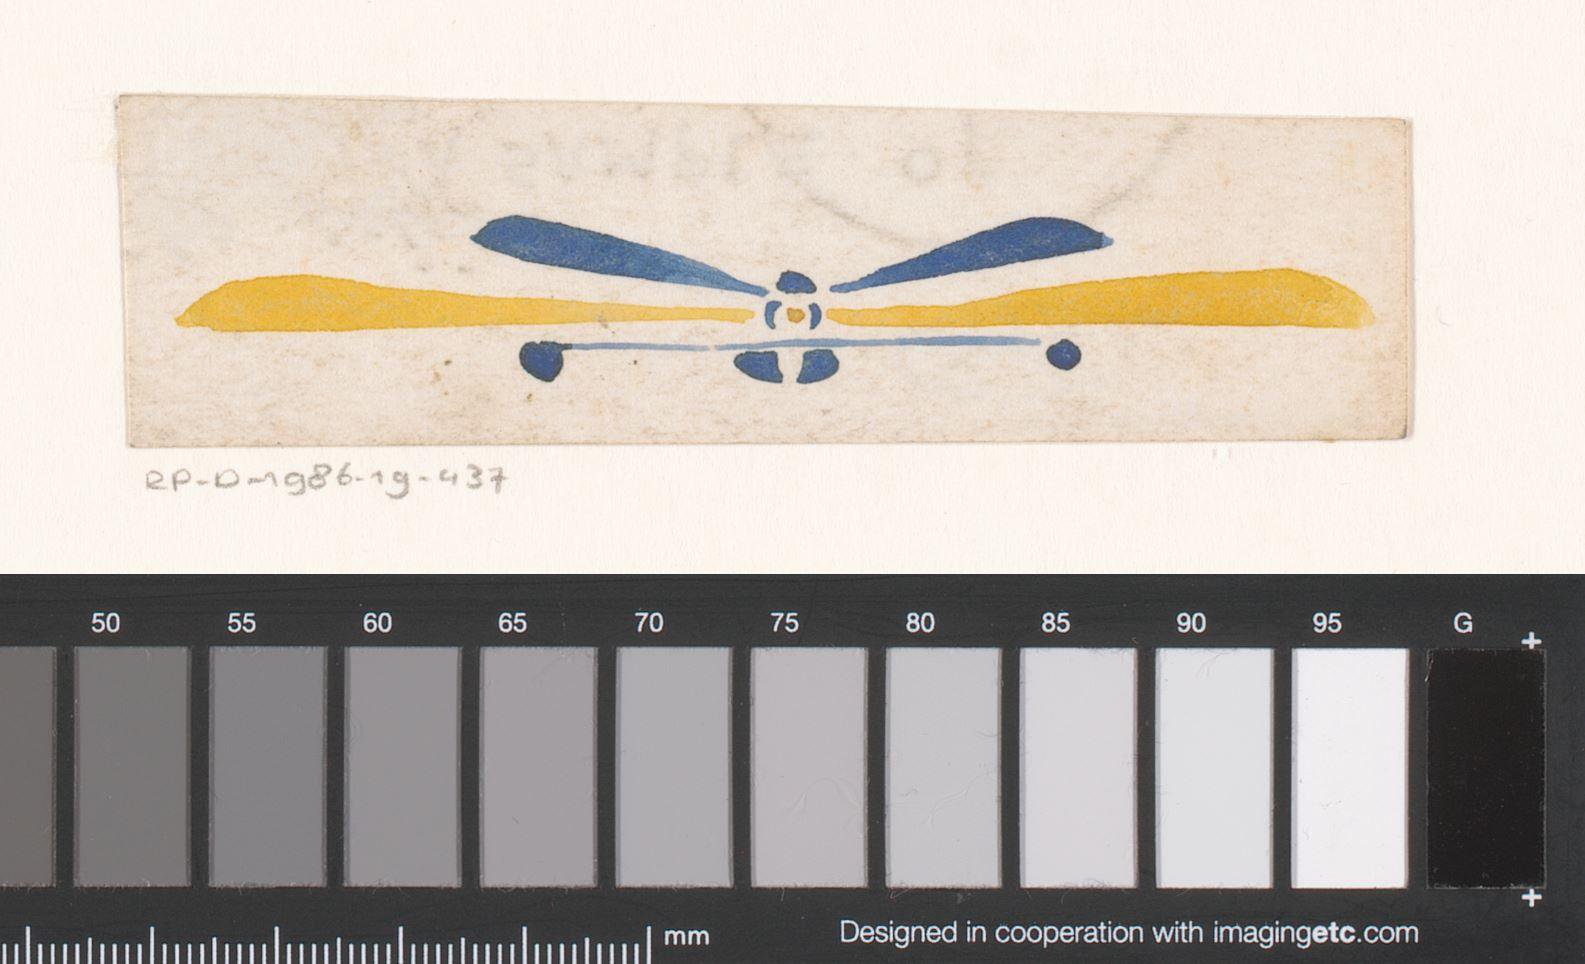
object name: drawing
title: Ontwerp voor een vignet met een gestileerd insect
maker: reinier willem petrus de vries (1874-1953)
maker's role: draughtsman, print maker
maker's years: 1874-1953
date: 1884-1952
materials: paper, watercolor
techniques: brush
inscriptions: collector's mark: ‘R:MVS.’